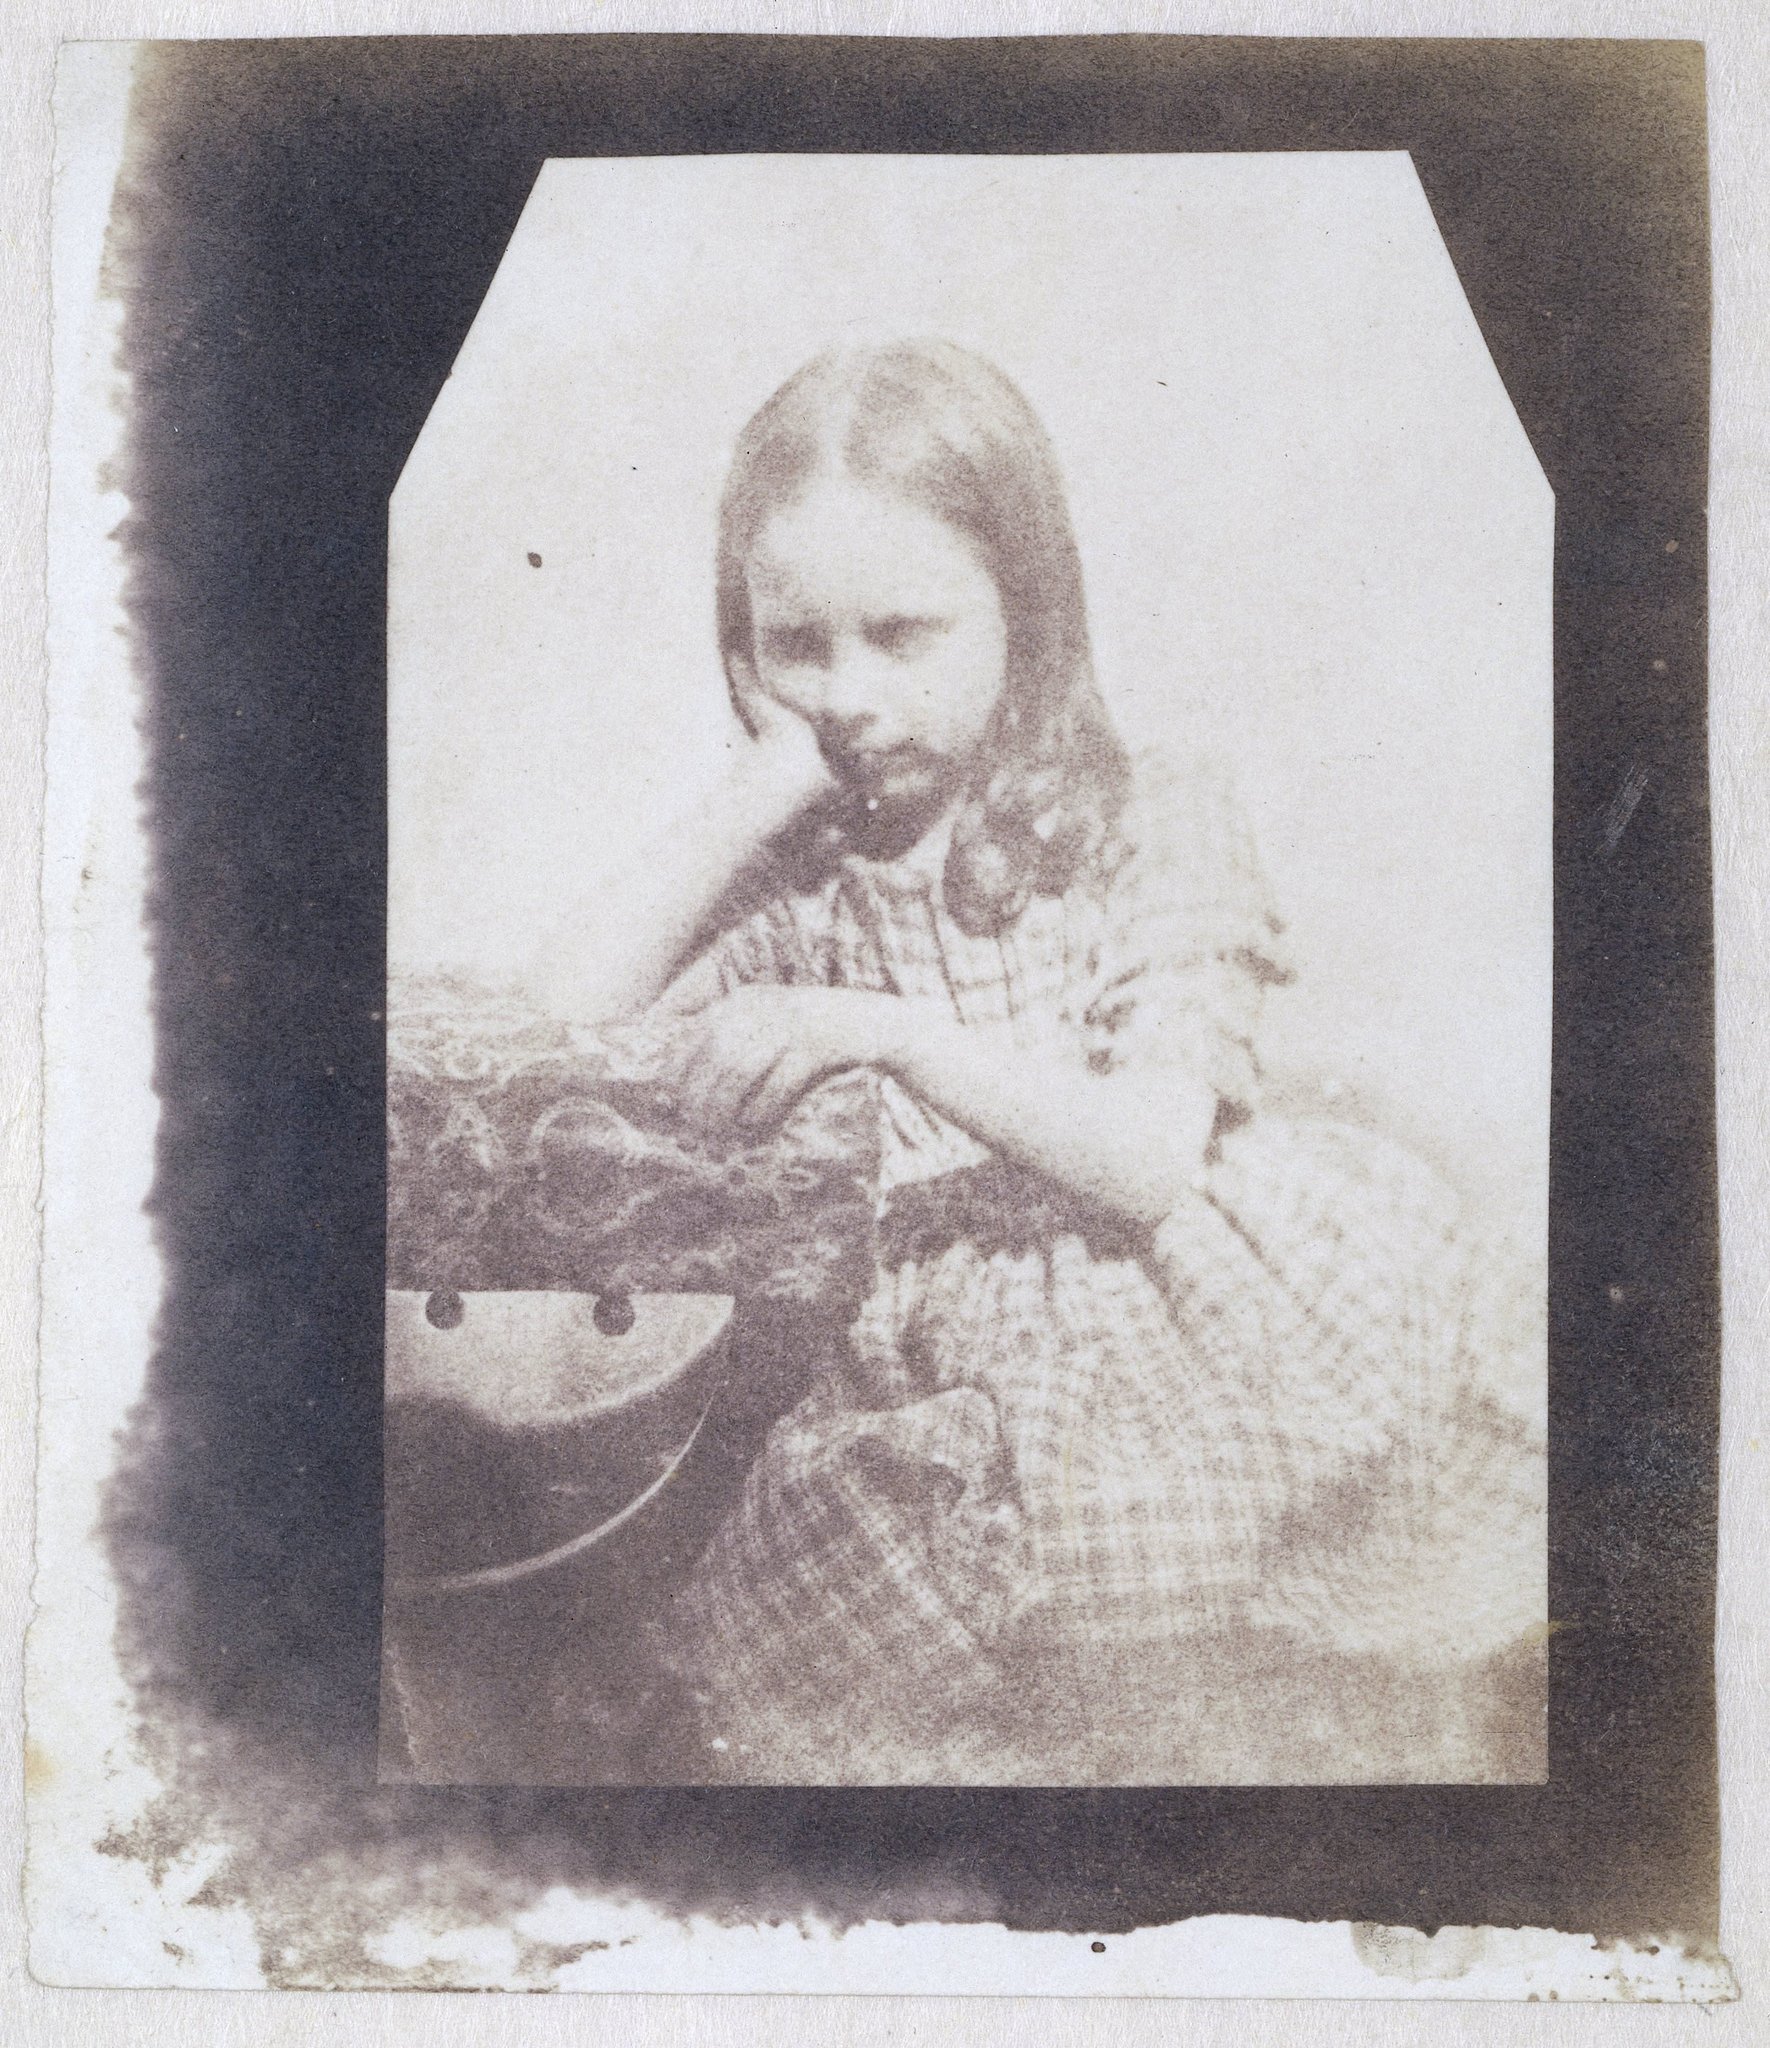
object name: photograph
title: Portrait of Rosamond Constance Talbot, the Photographer’s Daughter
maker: william henry fox talbot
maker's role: fotograaf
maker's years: 1800-1877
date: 1842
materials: photographic support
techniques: salted paper print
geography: england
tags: historical persons, girl (child between toddler and youth), england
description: In this little salted paper portrait taken by the British inventor of photography, the difference with the daguerreotype – the French invention of photography on a silvered copper plate – is quite distinct. A daguerreotype photograph is pinpoint-sharp and almost tangible in a magical way. In contrast, a paper photograph has soft lines and contours and is picturesque, like a drawing in sepia. Daguerreotype produced unique and one-off images, while paper photography was reproducible.